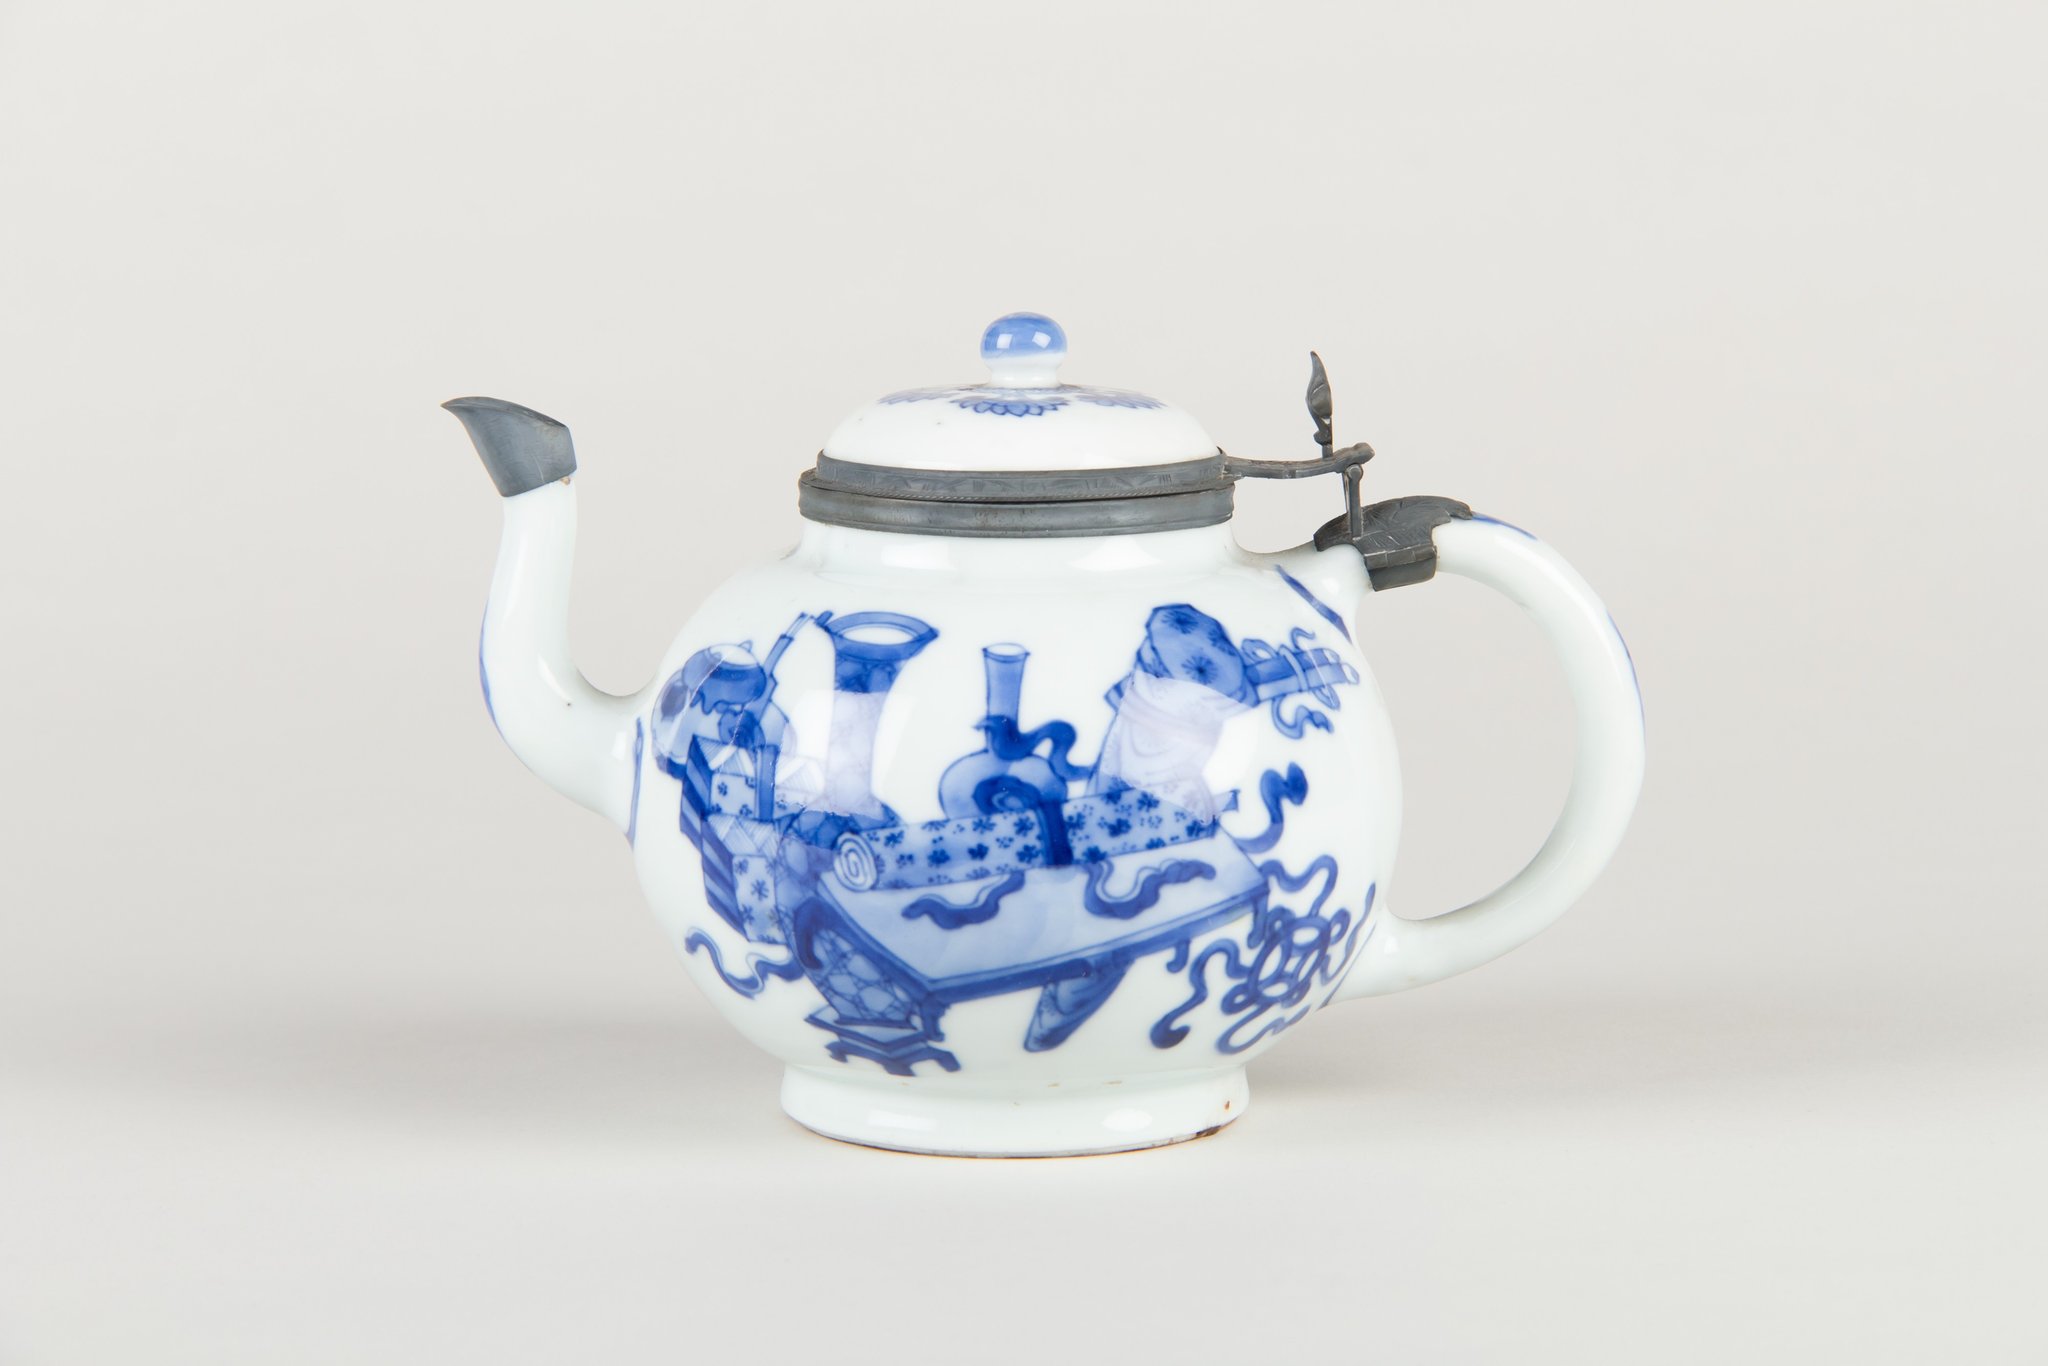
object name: teapot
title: Ewer with archaistic vessels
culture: chinese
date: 1667-1733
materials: cobalt, metal, porcelain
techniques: painting, underglaze